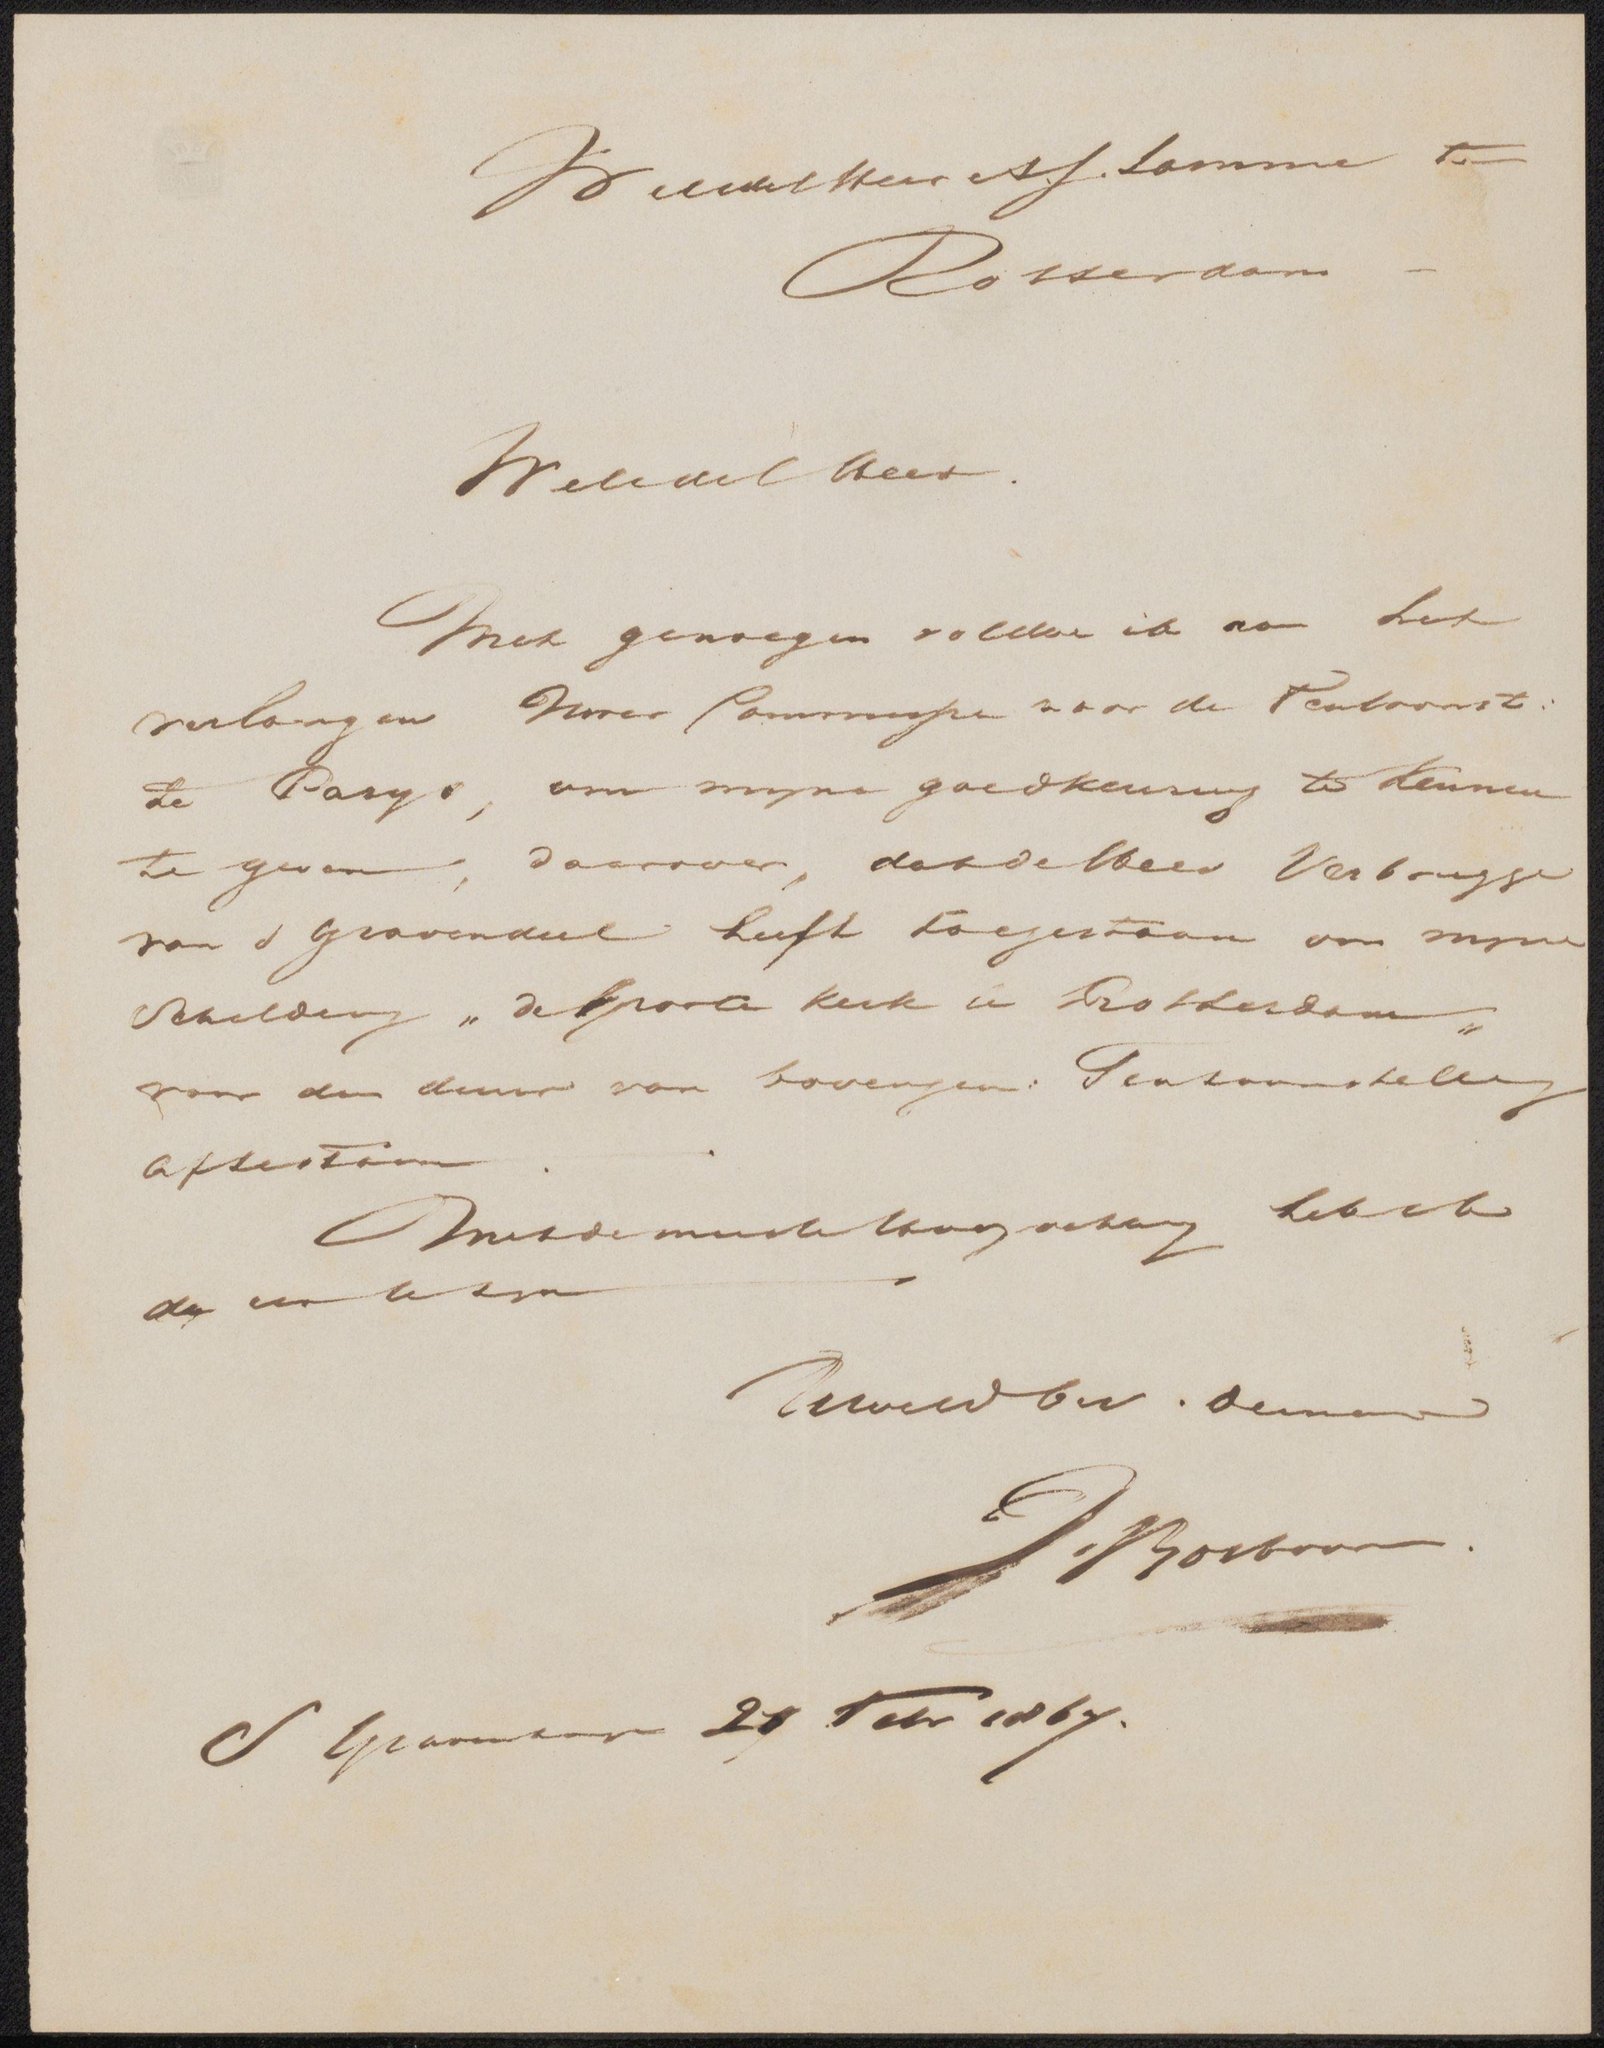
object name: letter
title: Brief aan Ary Johannes Lamme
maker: johannes bosboom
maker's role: draughtsman, painter, print maker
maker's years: 1817-1891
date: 1867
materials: ink, paper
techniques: pen, writing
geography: the hague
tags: dordrecht, print maker, draughtsman, ary johannes lamme, painting (including book-illumination, miniature-painting), exhibition ~ art, paris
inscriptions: collector's mark: Lugt 2228